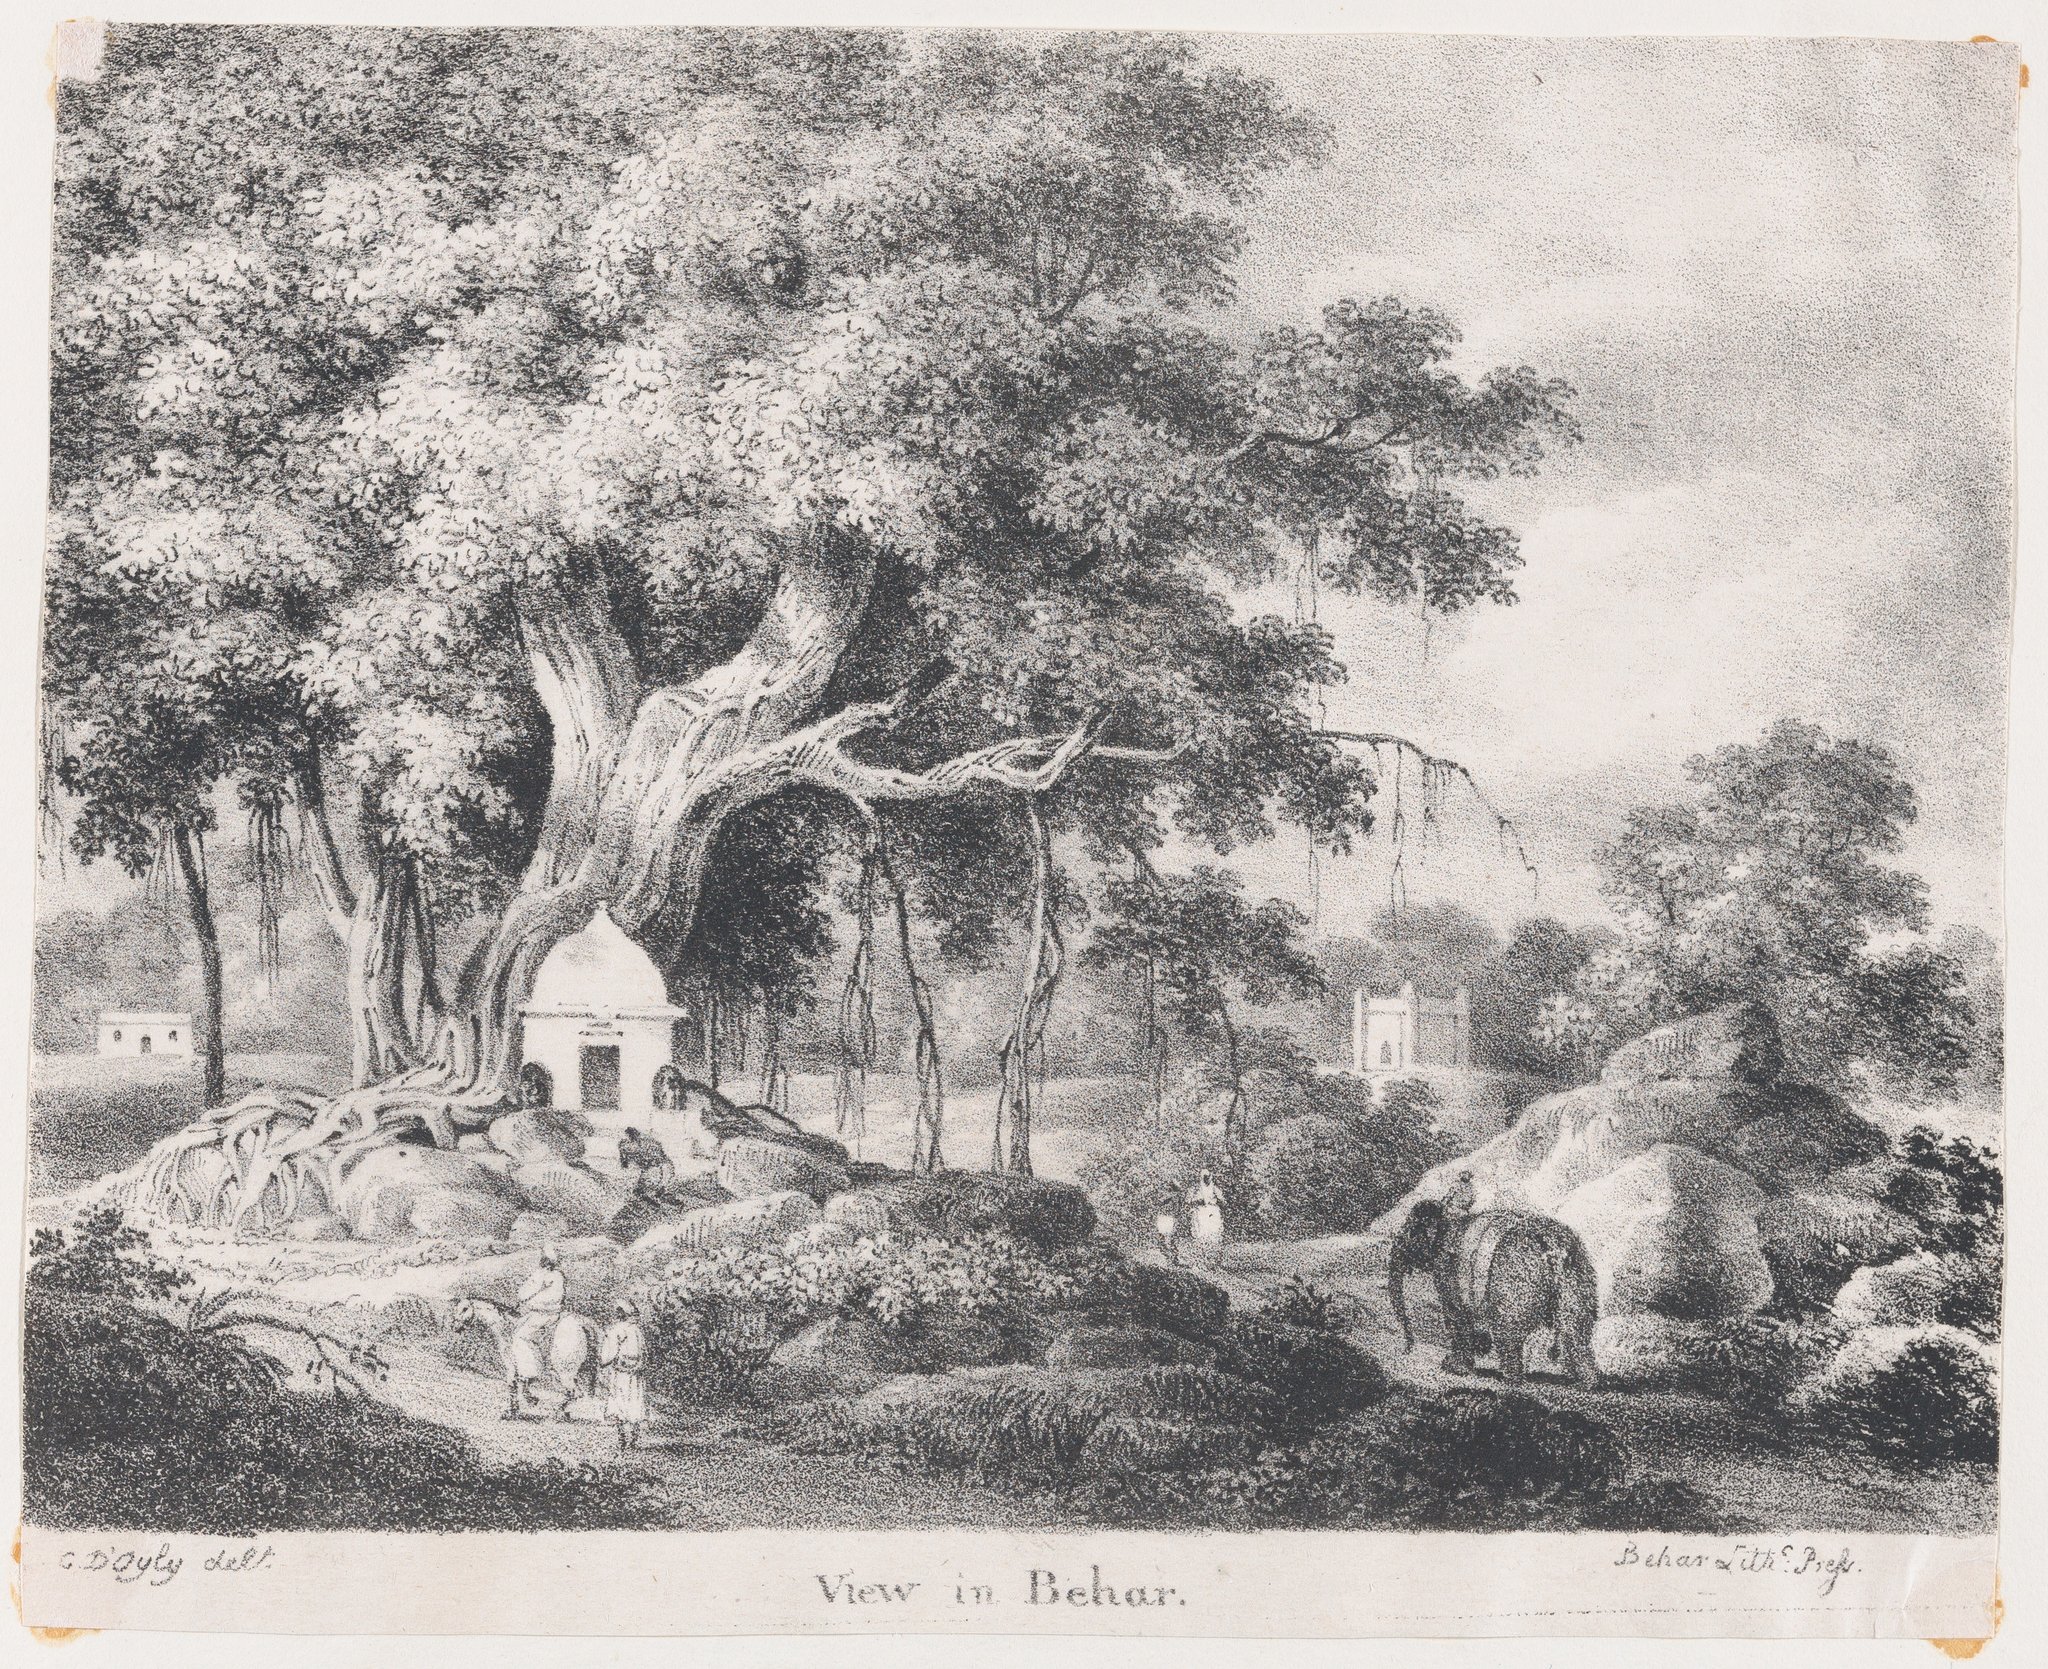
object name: print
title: View in Behar [Bihar], in an Anglo-Indian Album associated with Sir Charles D'Oyly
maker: sir charles d'oyly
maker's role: artist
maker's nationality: british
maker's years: 1781-1845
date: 1828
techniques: lithograph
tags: elephants,horses,landscapes